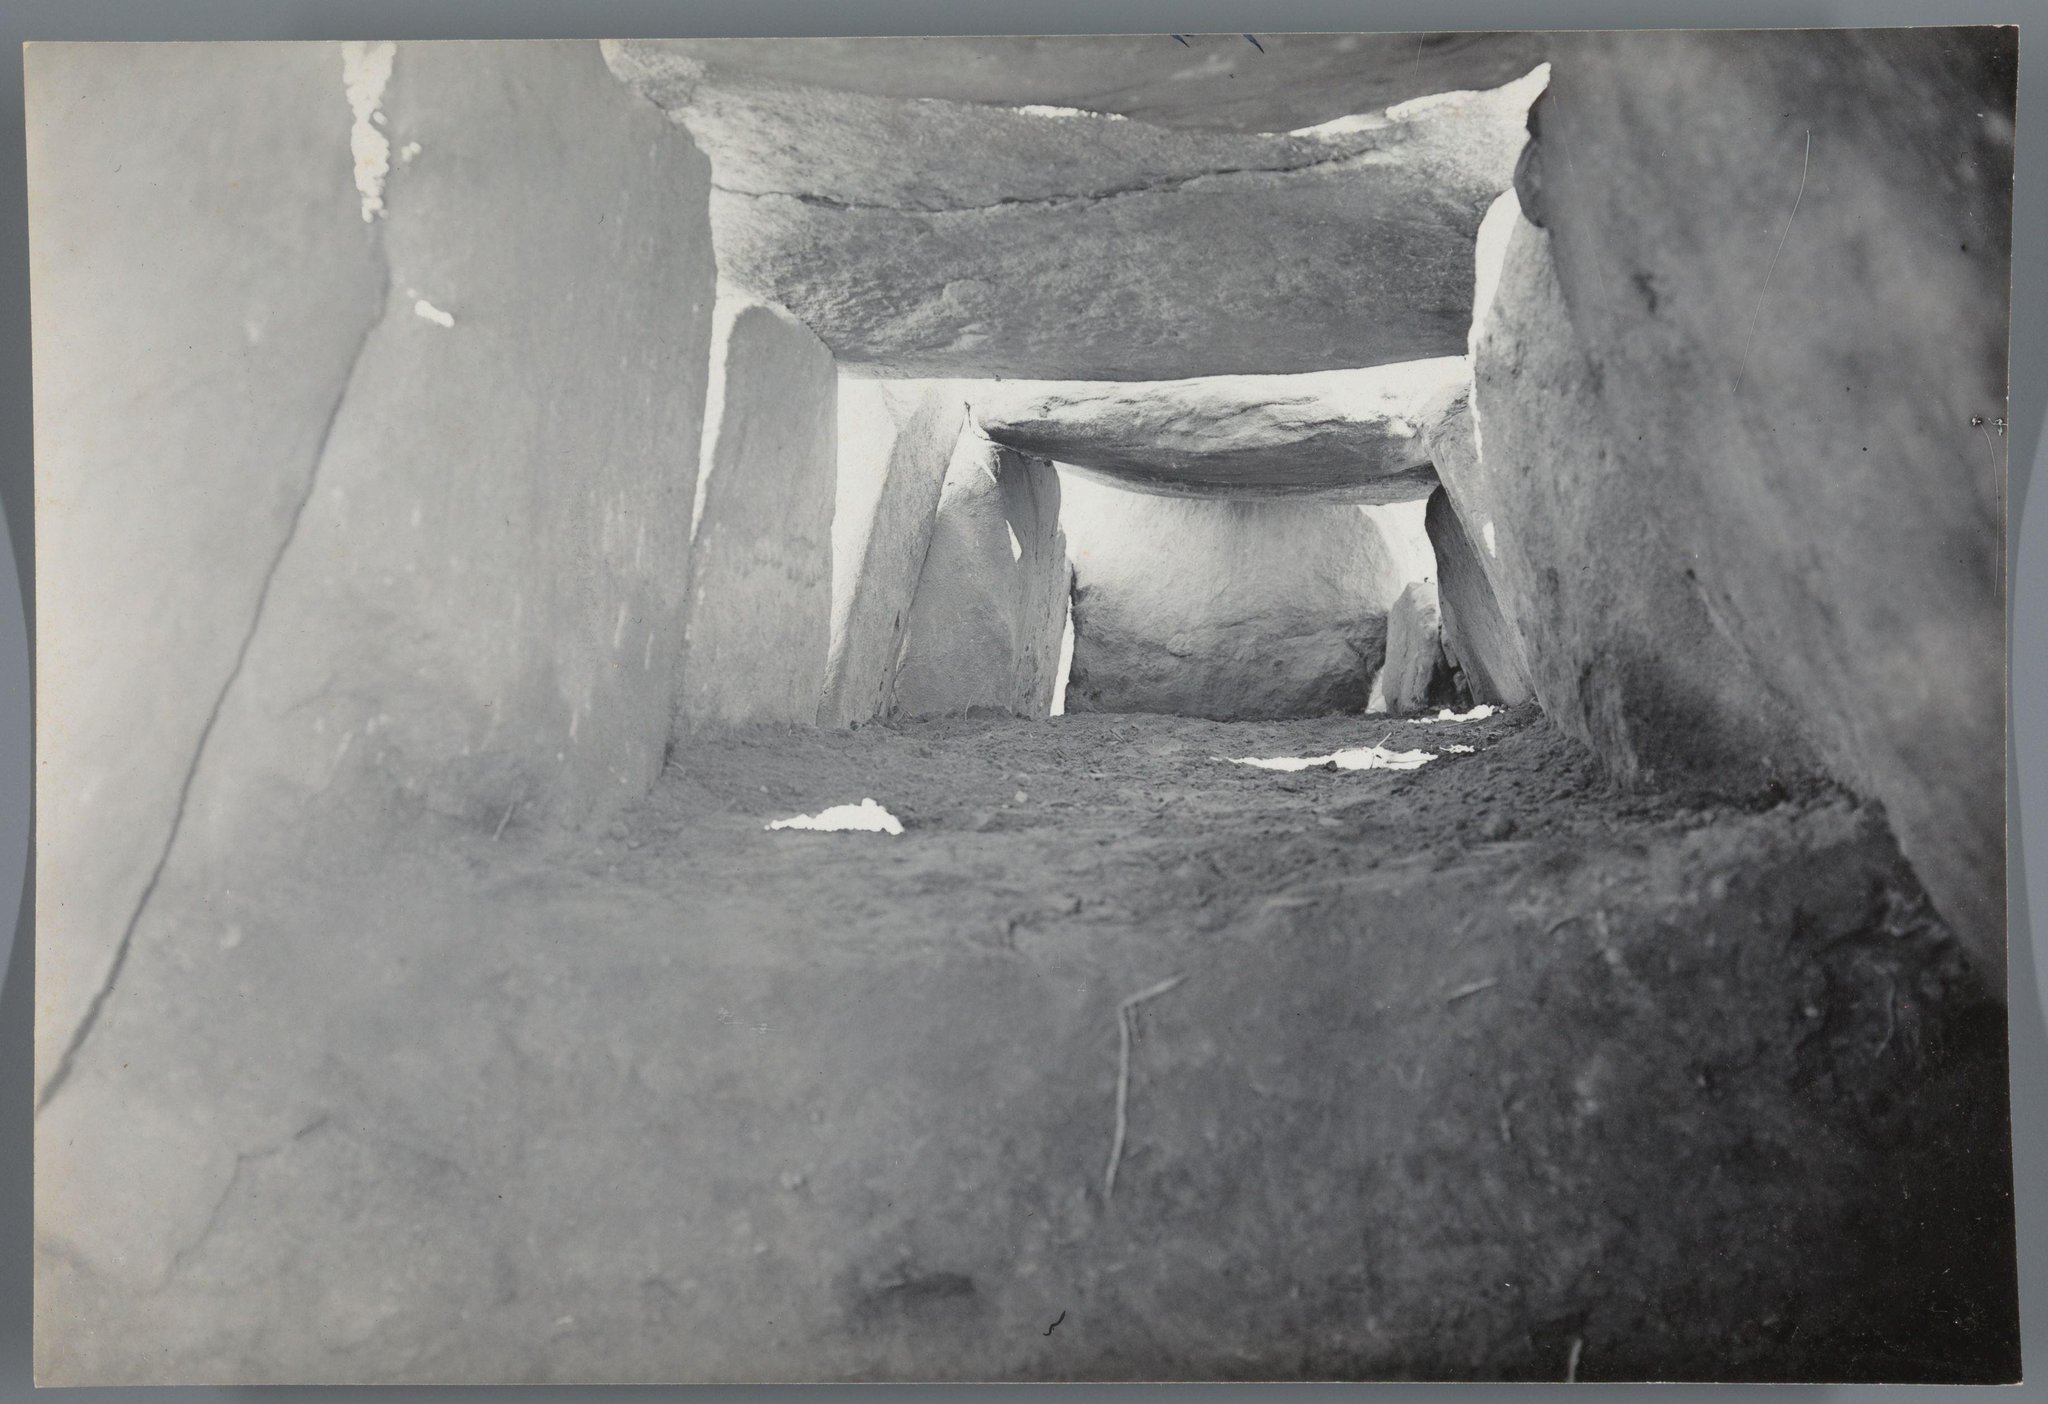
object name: photograph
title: Hunebed van Kerguntuil, Trégastel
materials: paper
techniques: gelatin silver print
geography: trégastel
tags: megalithic chambered tomb, dolmen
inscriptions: inscription: ‘afdr/ Ban v He/ Het inwendige van de/ allée couverte de Kergantuil/ Trégastel C. du N./ Z.O. richting’